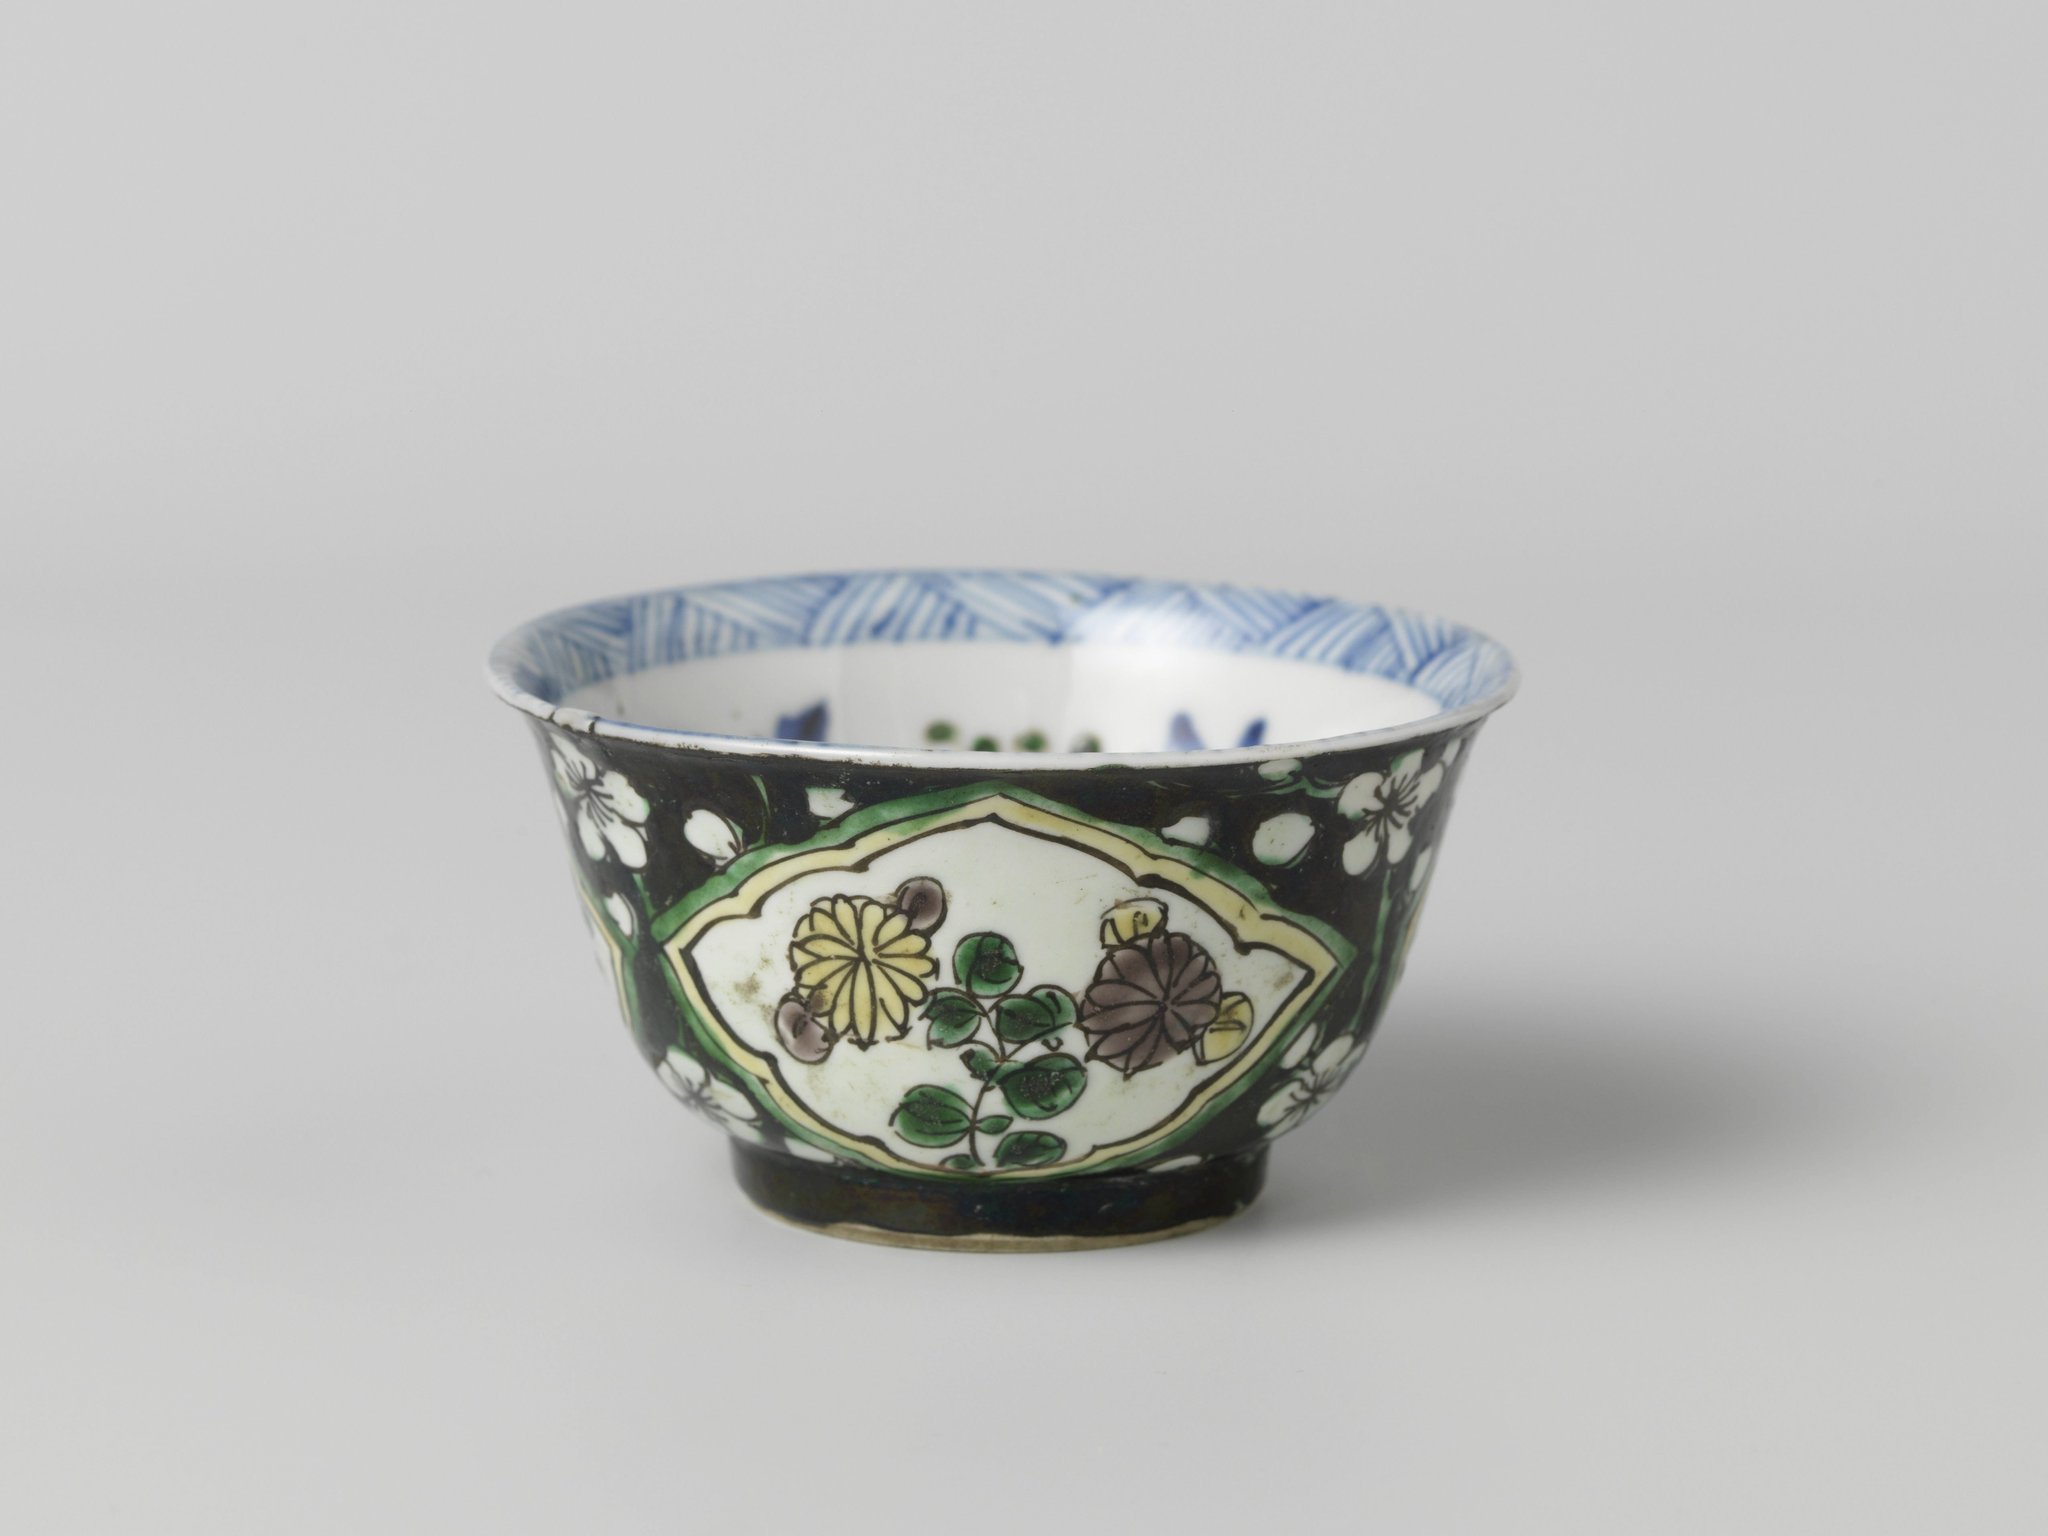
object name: cup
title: Cup with flower sprays in panels against a black ground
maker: Anonymous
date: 1725-1749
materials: cobalt, glaze, paint, porcelain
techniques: firing, turning, vitrification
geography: china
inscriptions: mark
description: Kop, famille noire, op de zwarte buitenzijde drie ruitvormige reserves met gekleurde bloemtakjes.